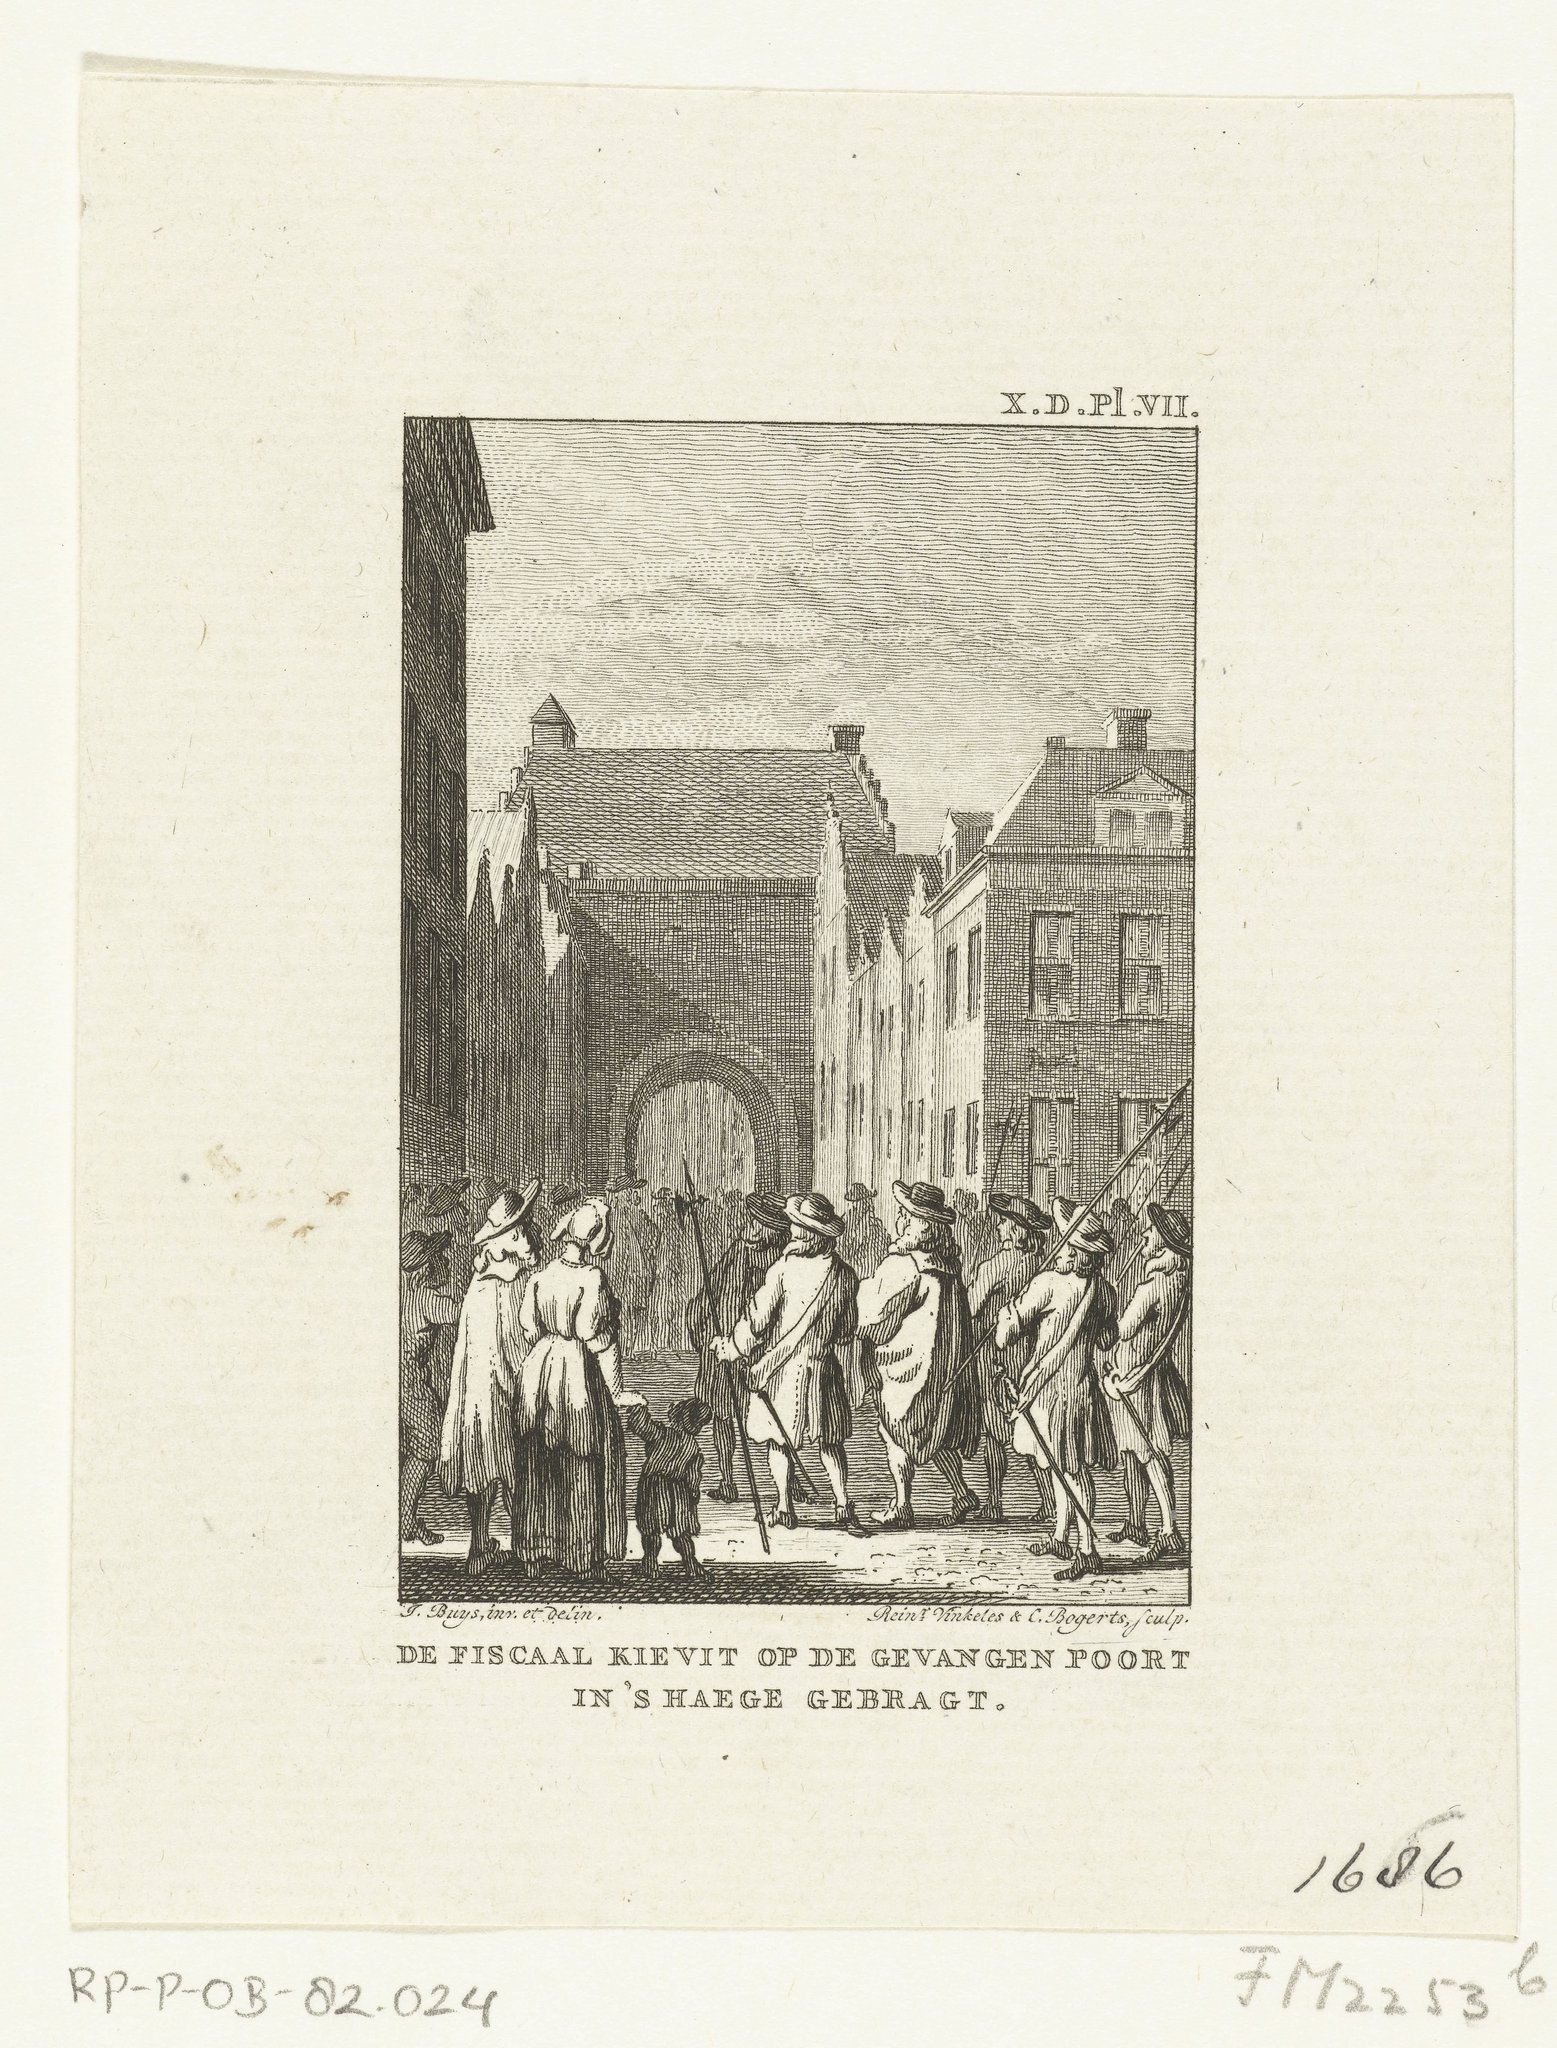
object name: history print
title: De advocaat-fiscaal Kievit wordt naar de Gevangenpoort gebracht, 1686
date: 1780-1795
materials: paper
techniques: etching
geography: northern netherlands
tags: transport (of arrested person)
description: Gebruikt als illustratie in: J. Fokke, Geschiedenissen der Vereenigde Nederlanden voor de vaderlandsche jeugd, Johannes Allart, Amsterdam 1783-1795, 25 delen, dl. X, pl. VII. Deze plaat behoort bij de prenten over het jaar 1686.